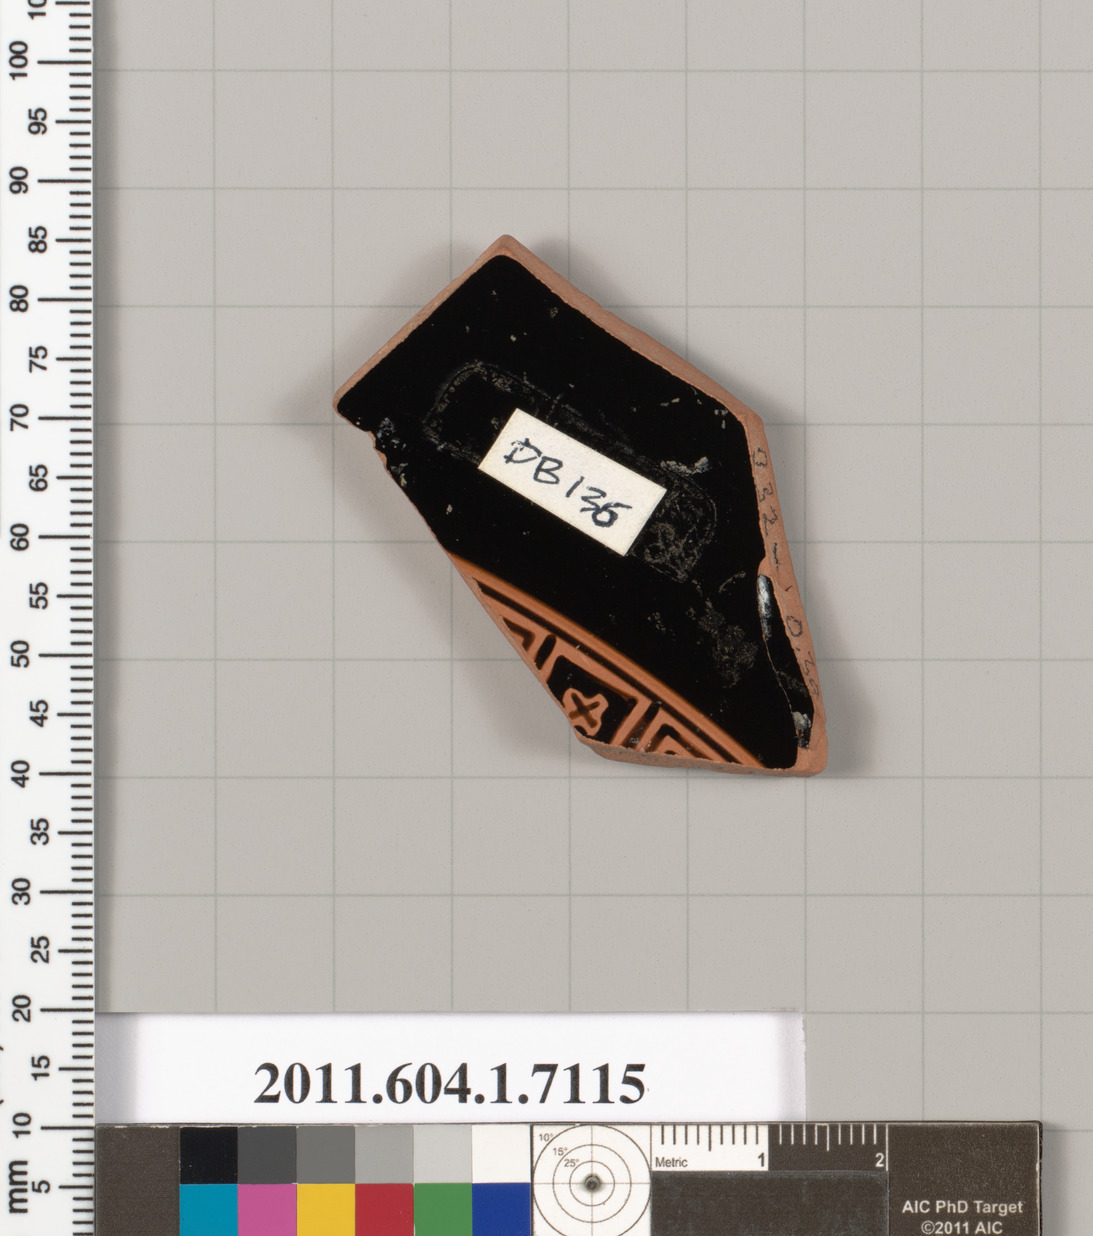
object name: kylix fragment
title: Terracotta fragment of a kylix (drinking cup)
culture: greek, attic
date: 500-480 BCE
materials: terracotta